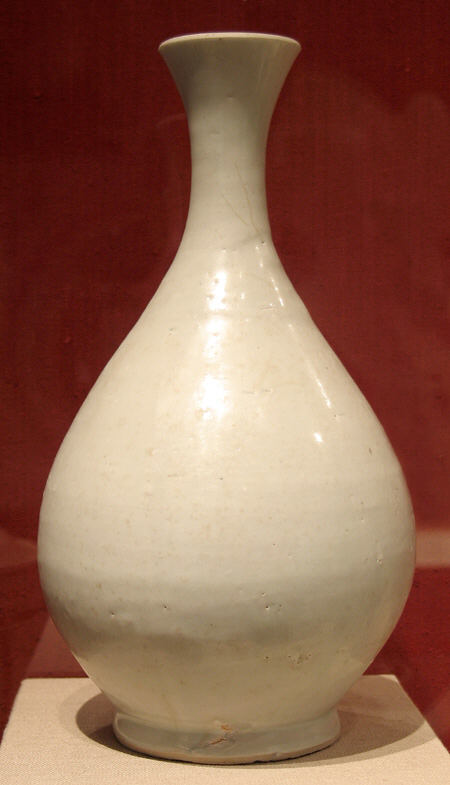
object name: vase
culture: vietnamese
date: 1401-1600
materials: glaze, stoneware